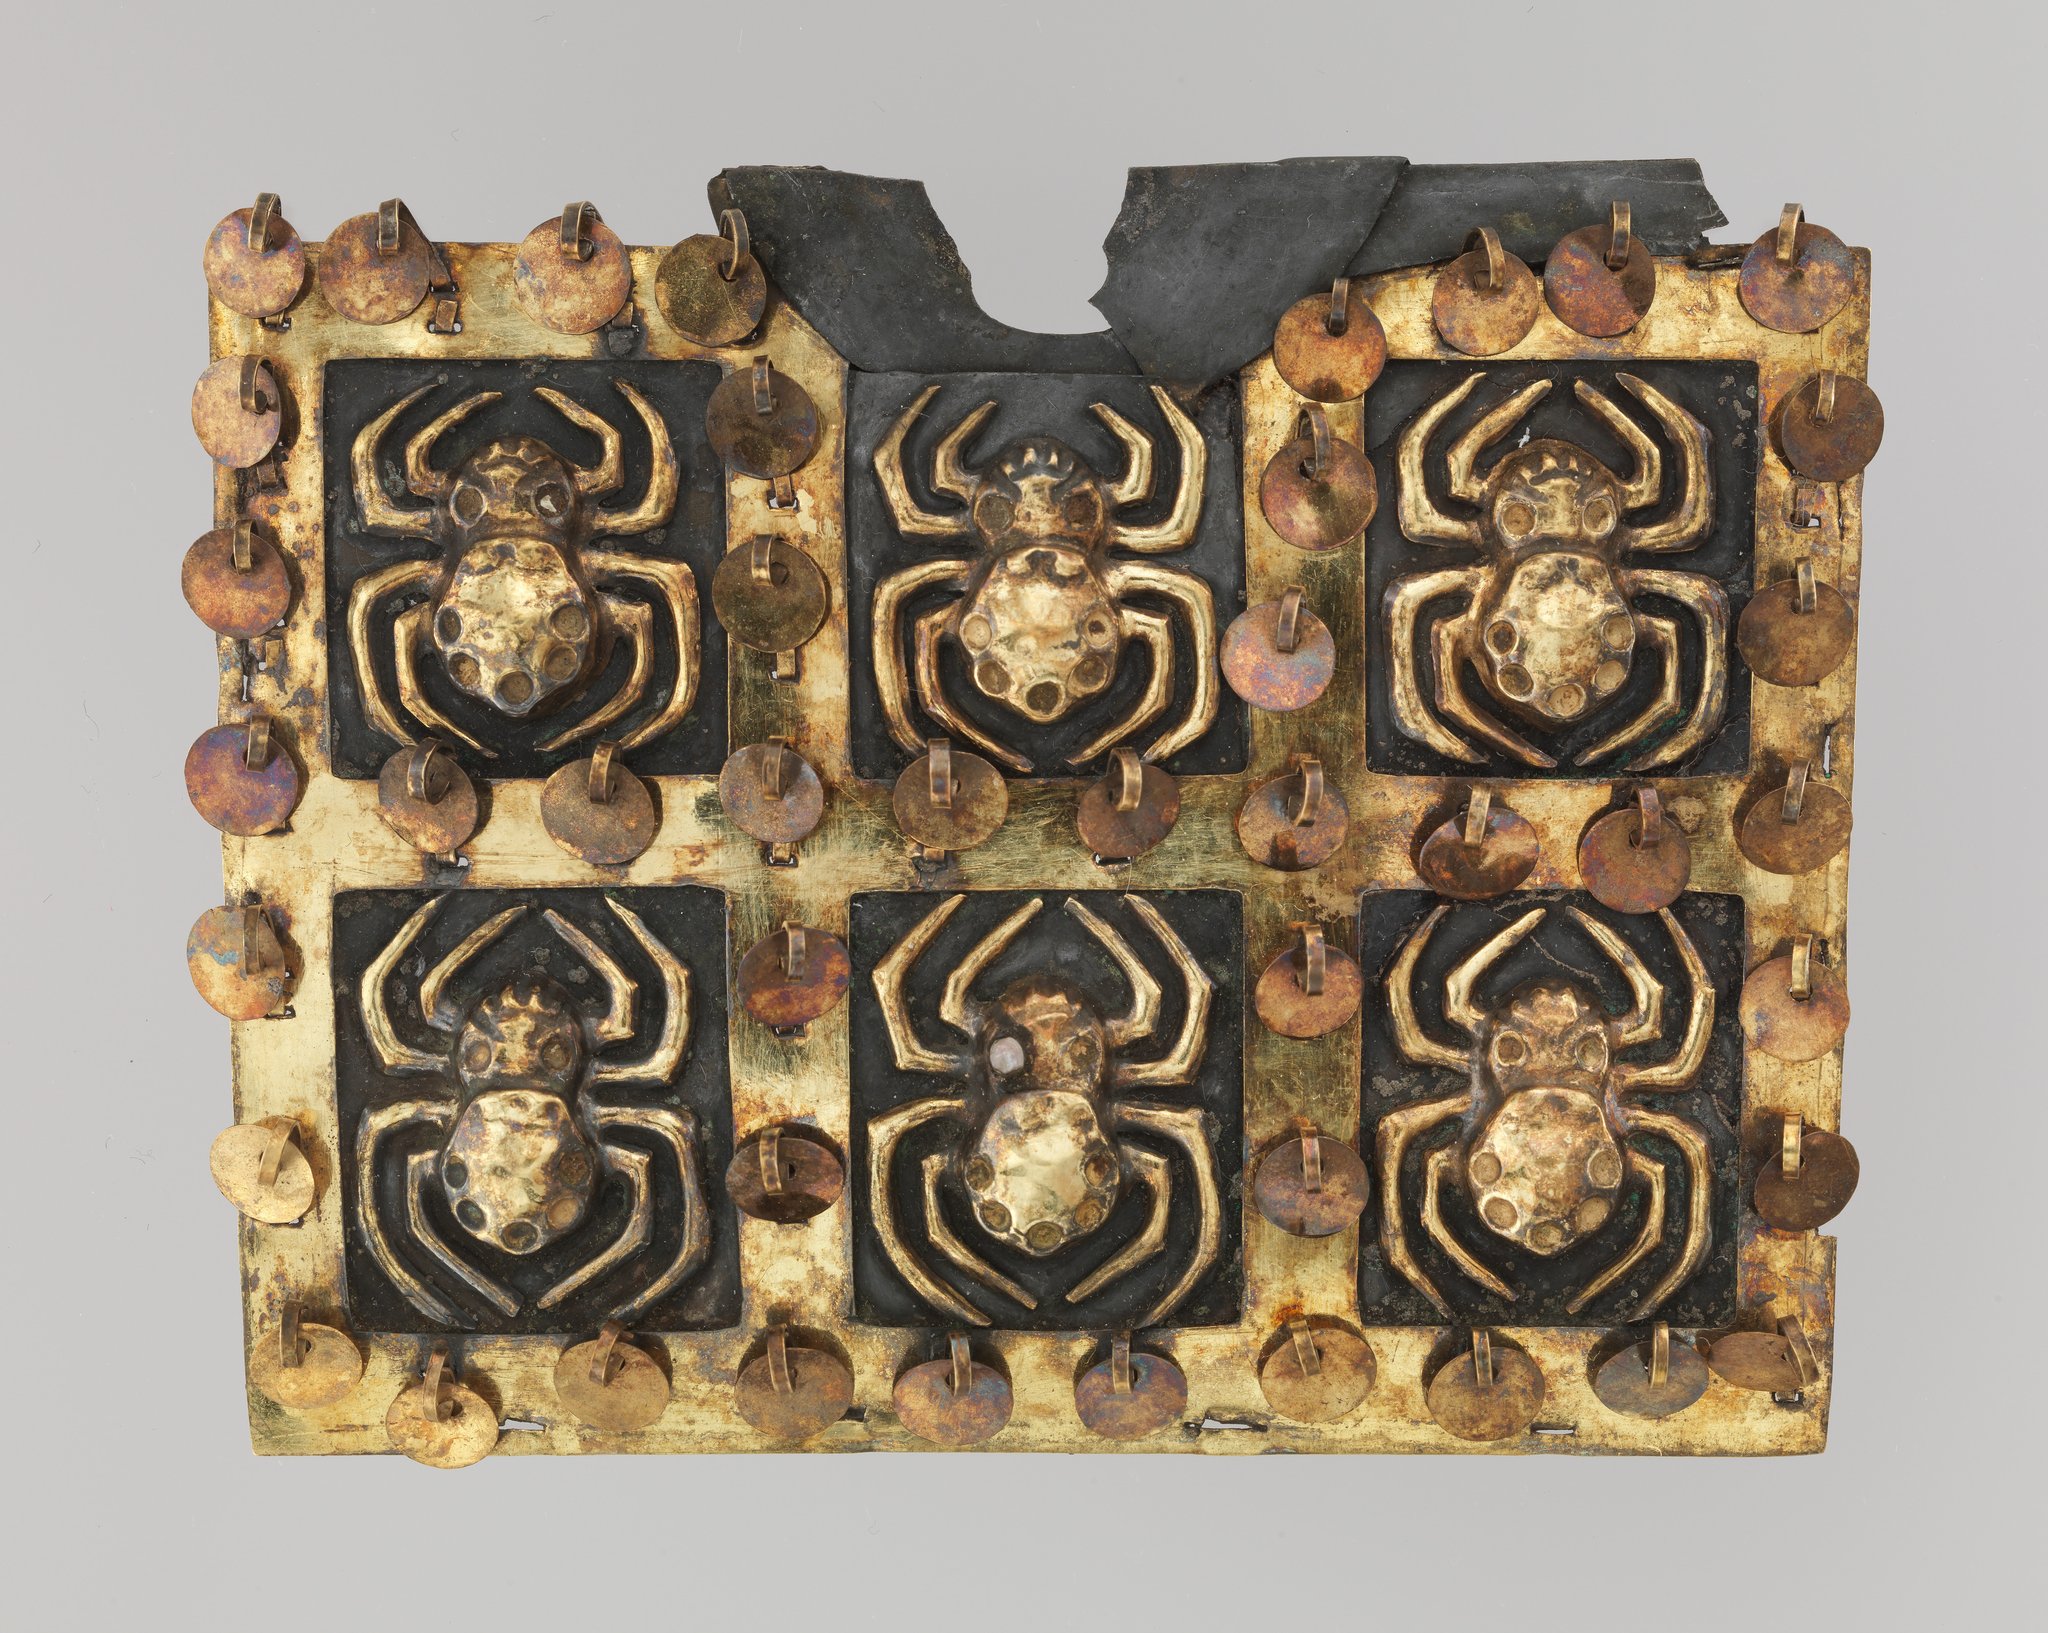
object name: nose ornament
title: Nose ornament with spiders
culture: moche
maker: moche artist(s)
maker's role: artist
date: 200-900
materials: gold, shell, silver, stone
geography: peru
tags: spiders